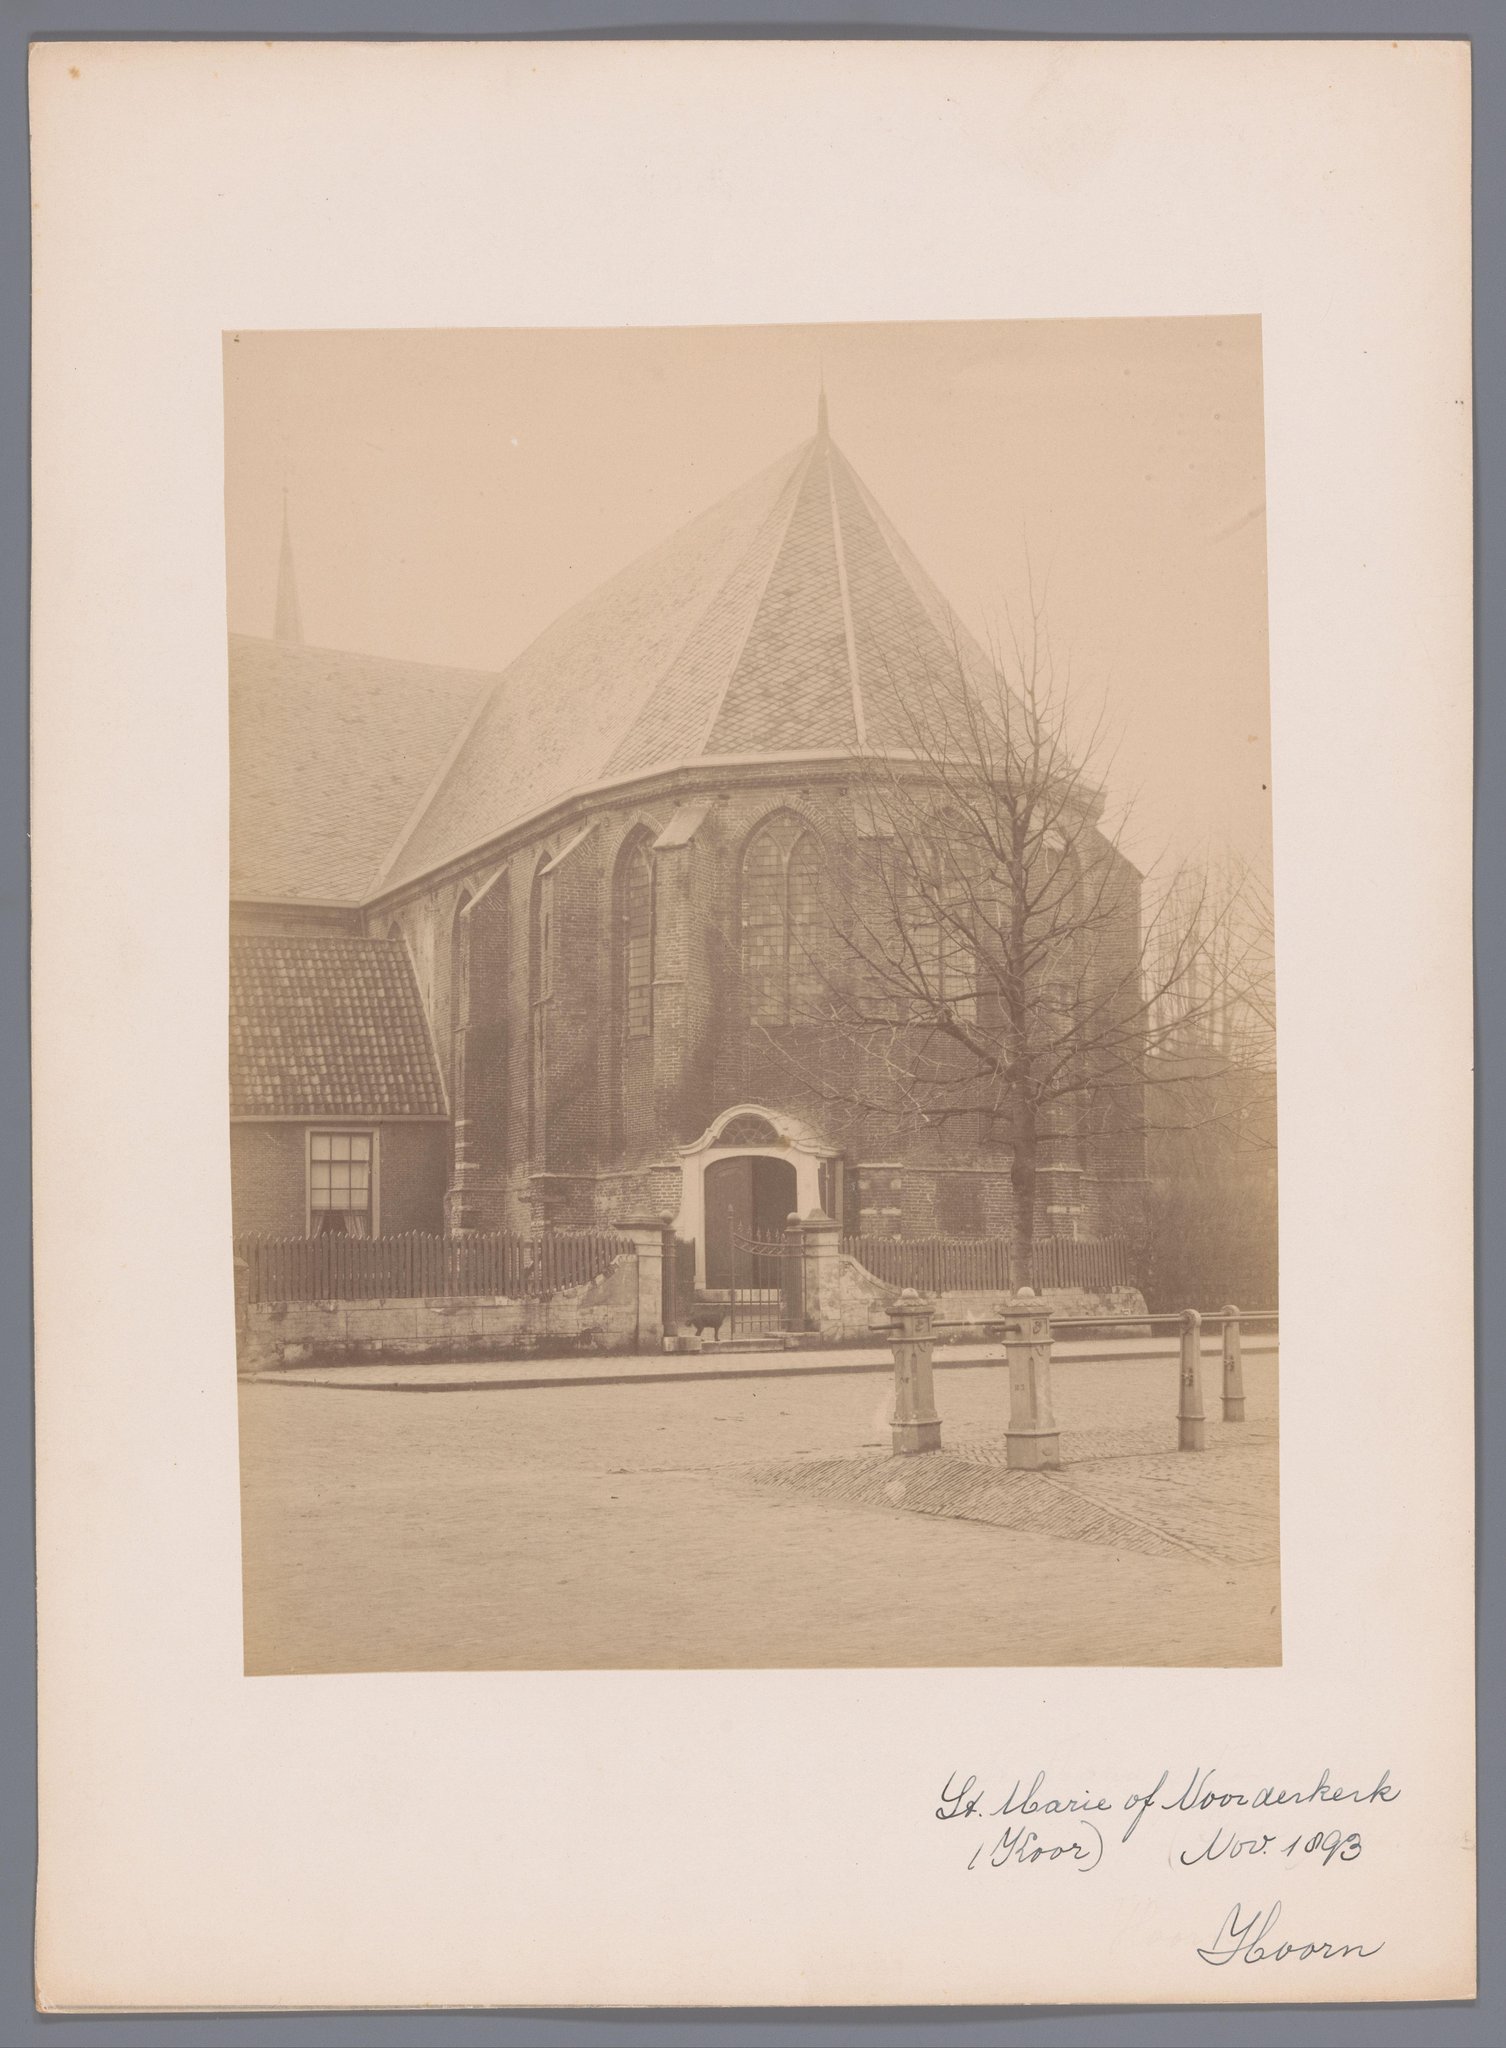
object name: photograph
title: Gezicht op het koor van de Noorderkerk te Hoorn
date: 1893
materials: cardboard, photographic support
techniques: albumen print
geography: hoorn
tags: church (exterior), parts of church interior: choir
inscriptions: annotation: ‘Hoorn (N.H.)/ Koor v/d Noorderkerk/ Nov. 1893’, annotation: ‘St. Harie of Noorderkerk/ (Koor) Nov. 1893/ Hoorn’